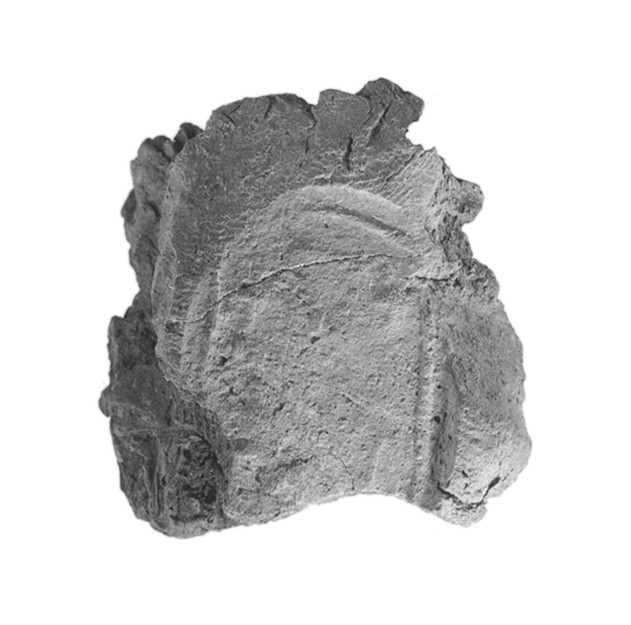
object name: sealing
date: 2030-1640 BCE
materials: clay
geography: egypt